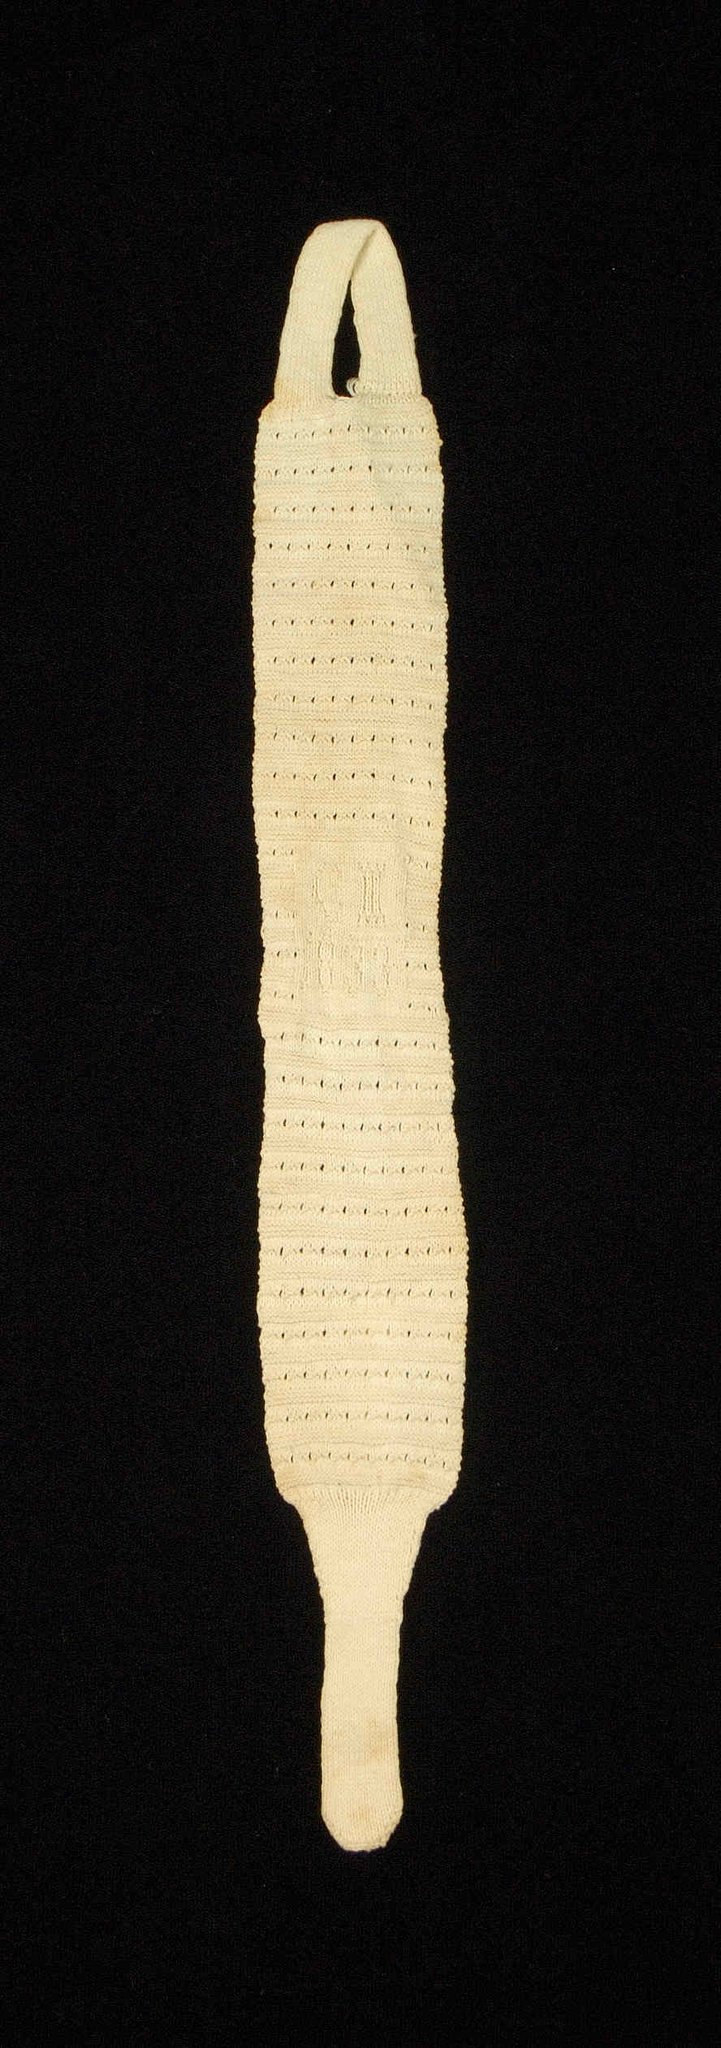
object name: garter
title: Garters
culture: american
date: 1833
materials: cotton